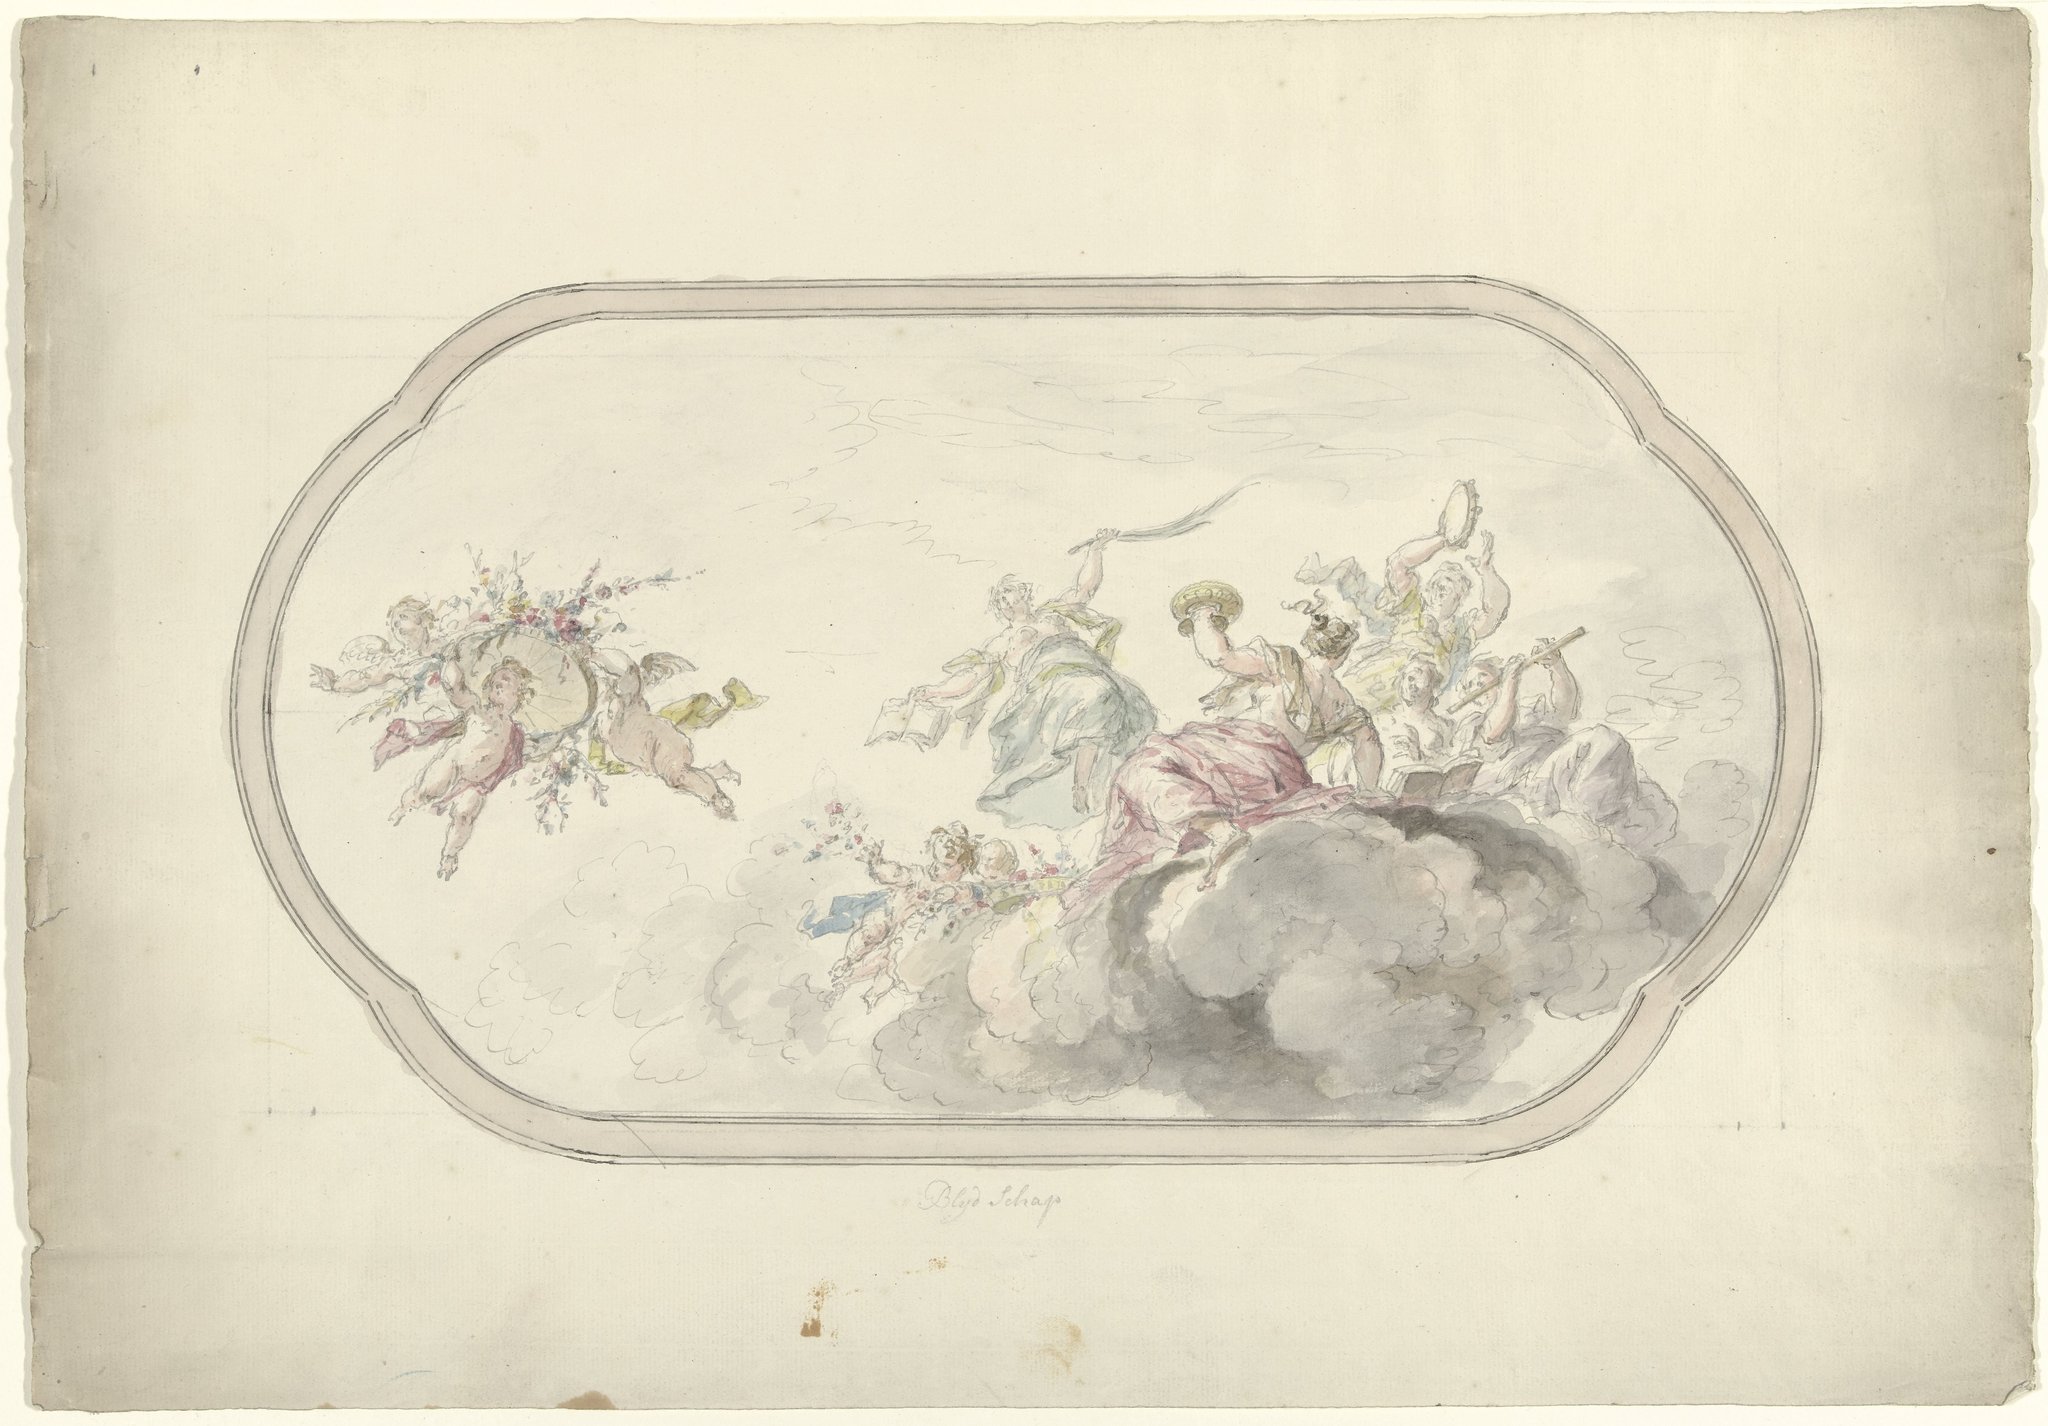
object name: watercolor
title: Ontwerp voor een plafondschildering met musicerende vrouwen en putti met bloemenmand als allegorie op Blijdschap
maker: dionys van nijmegen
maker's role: draughtsman, painter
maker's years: 1705-1798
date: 1715-1798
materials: ink, paper, pencil, watercolor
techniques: brush, pen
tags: small group of musicians, chamber orchestra, jazz band, pleasure, enjoyment, joy; 'allegrezza', 'allegrezza da le medaglie', 'allegrezza, letitia e giubilo', 'diletto', 'piacere', 'piacere honesto' (ripa), sitting or standing on clouds